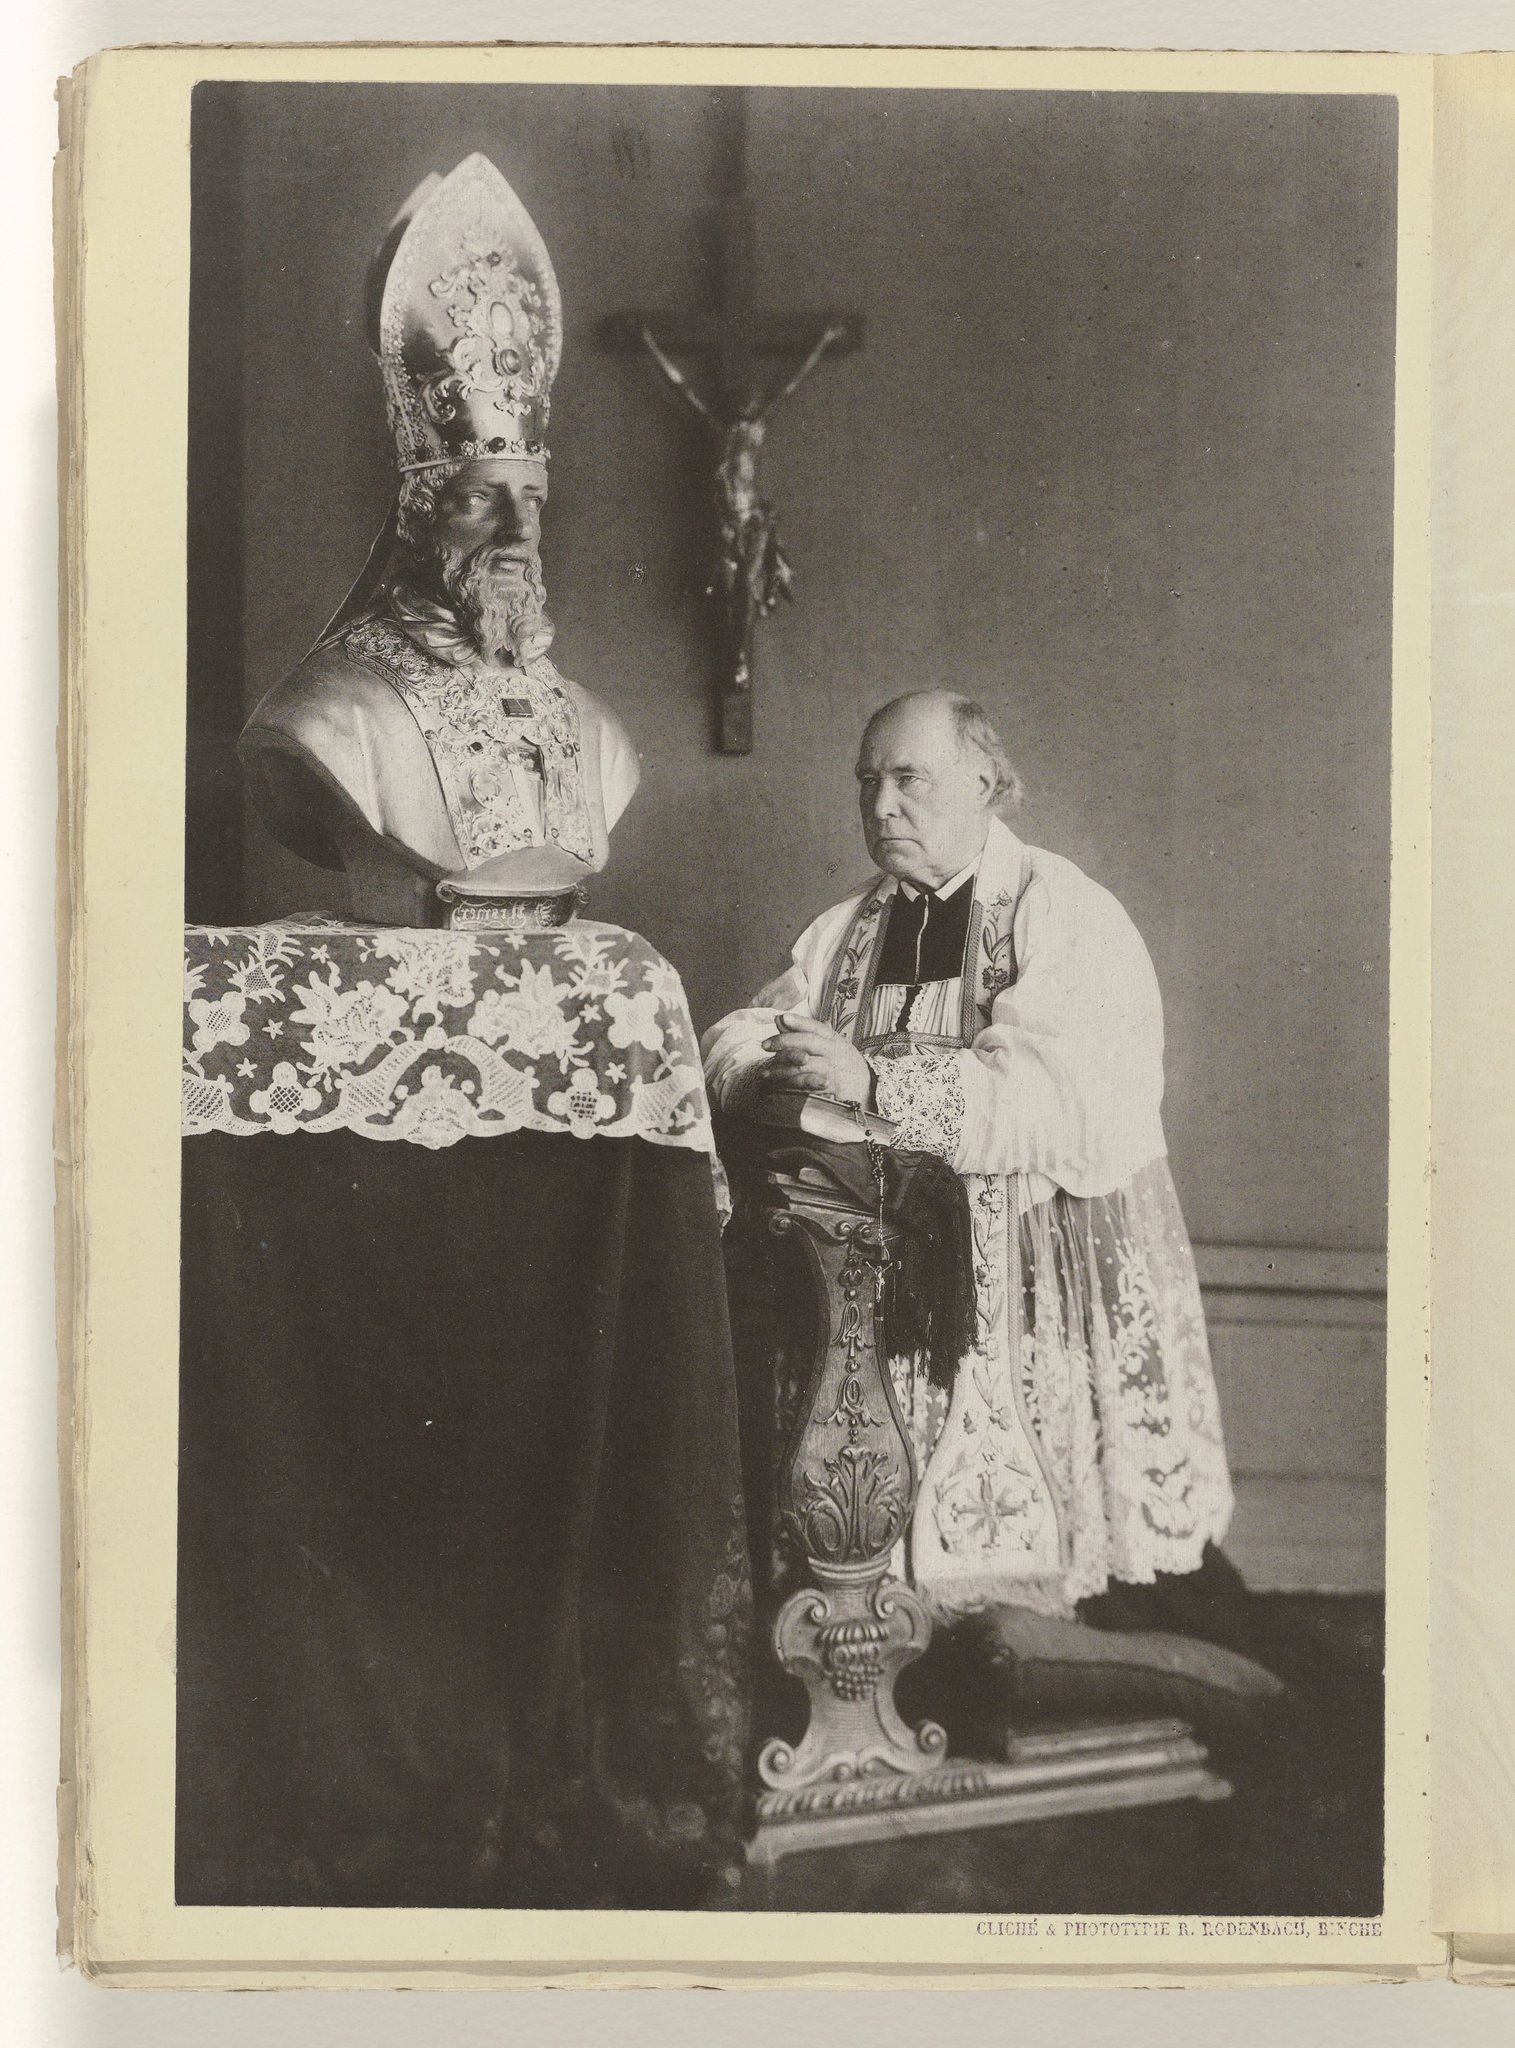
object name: photograph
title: Buste de Saint Ursmer, style de la Renaissance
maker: r. rodenbach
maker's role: fotograaf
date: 1885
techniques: carbon print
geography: binche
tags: male saints (with name)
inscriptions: inscription: ‘CLICHÉ & PHOTOTYPIE R. RODENBACH, BINCHE’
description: Onderdeel van 'Saint Ursmer : sa vie, ses compagnons, ses miracles et son culte', 1885.